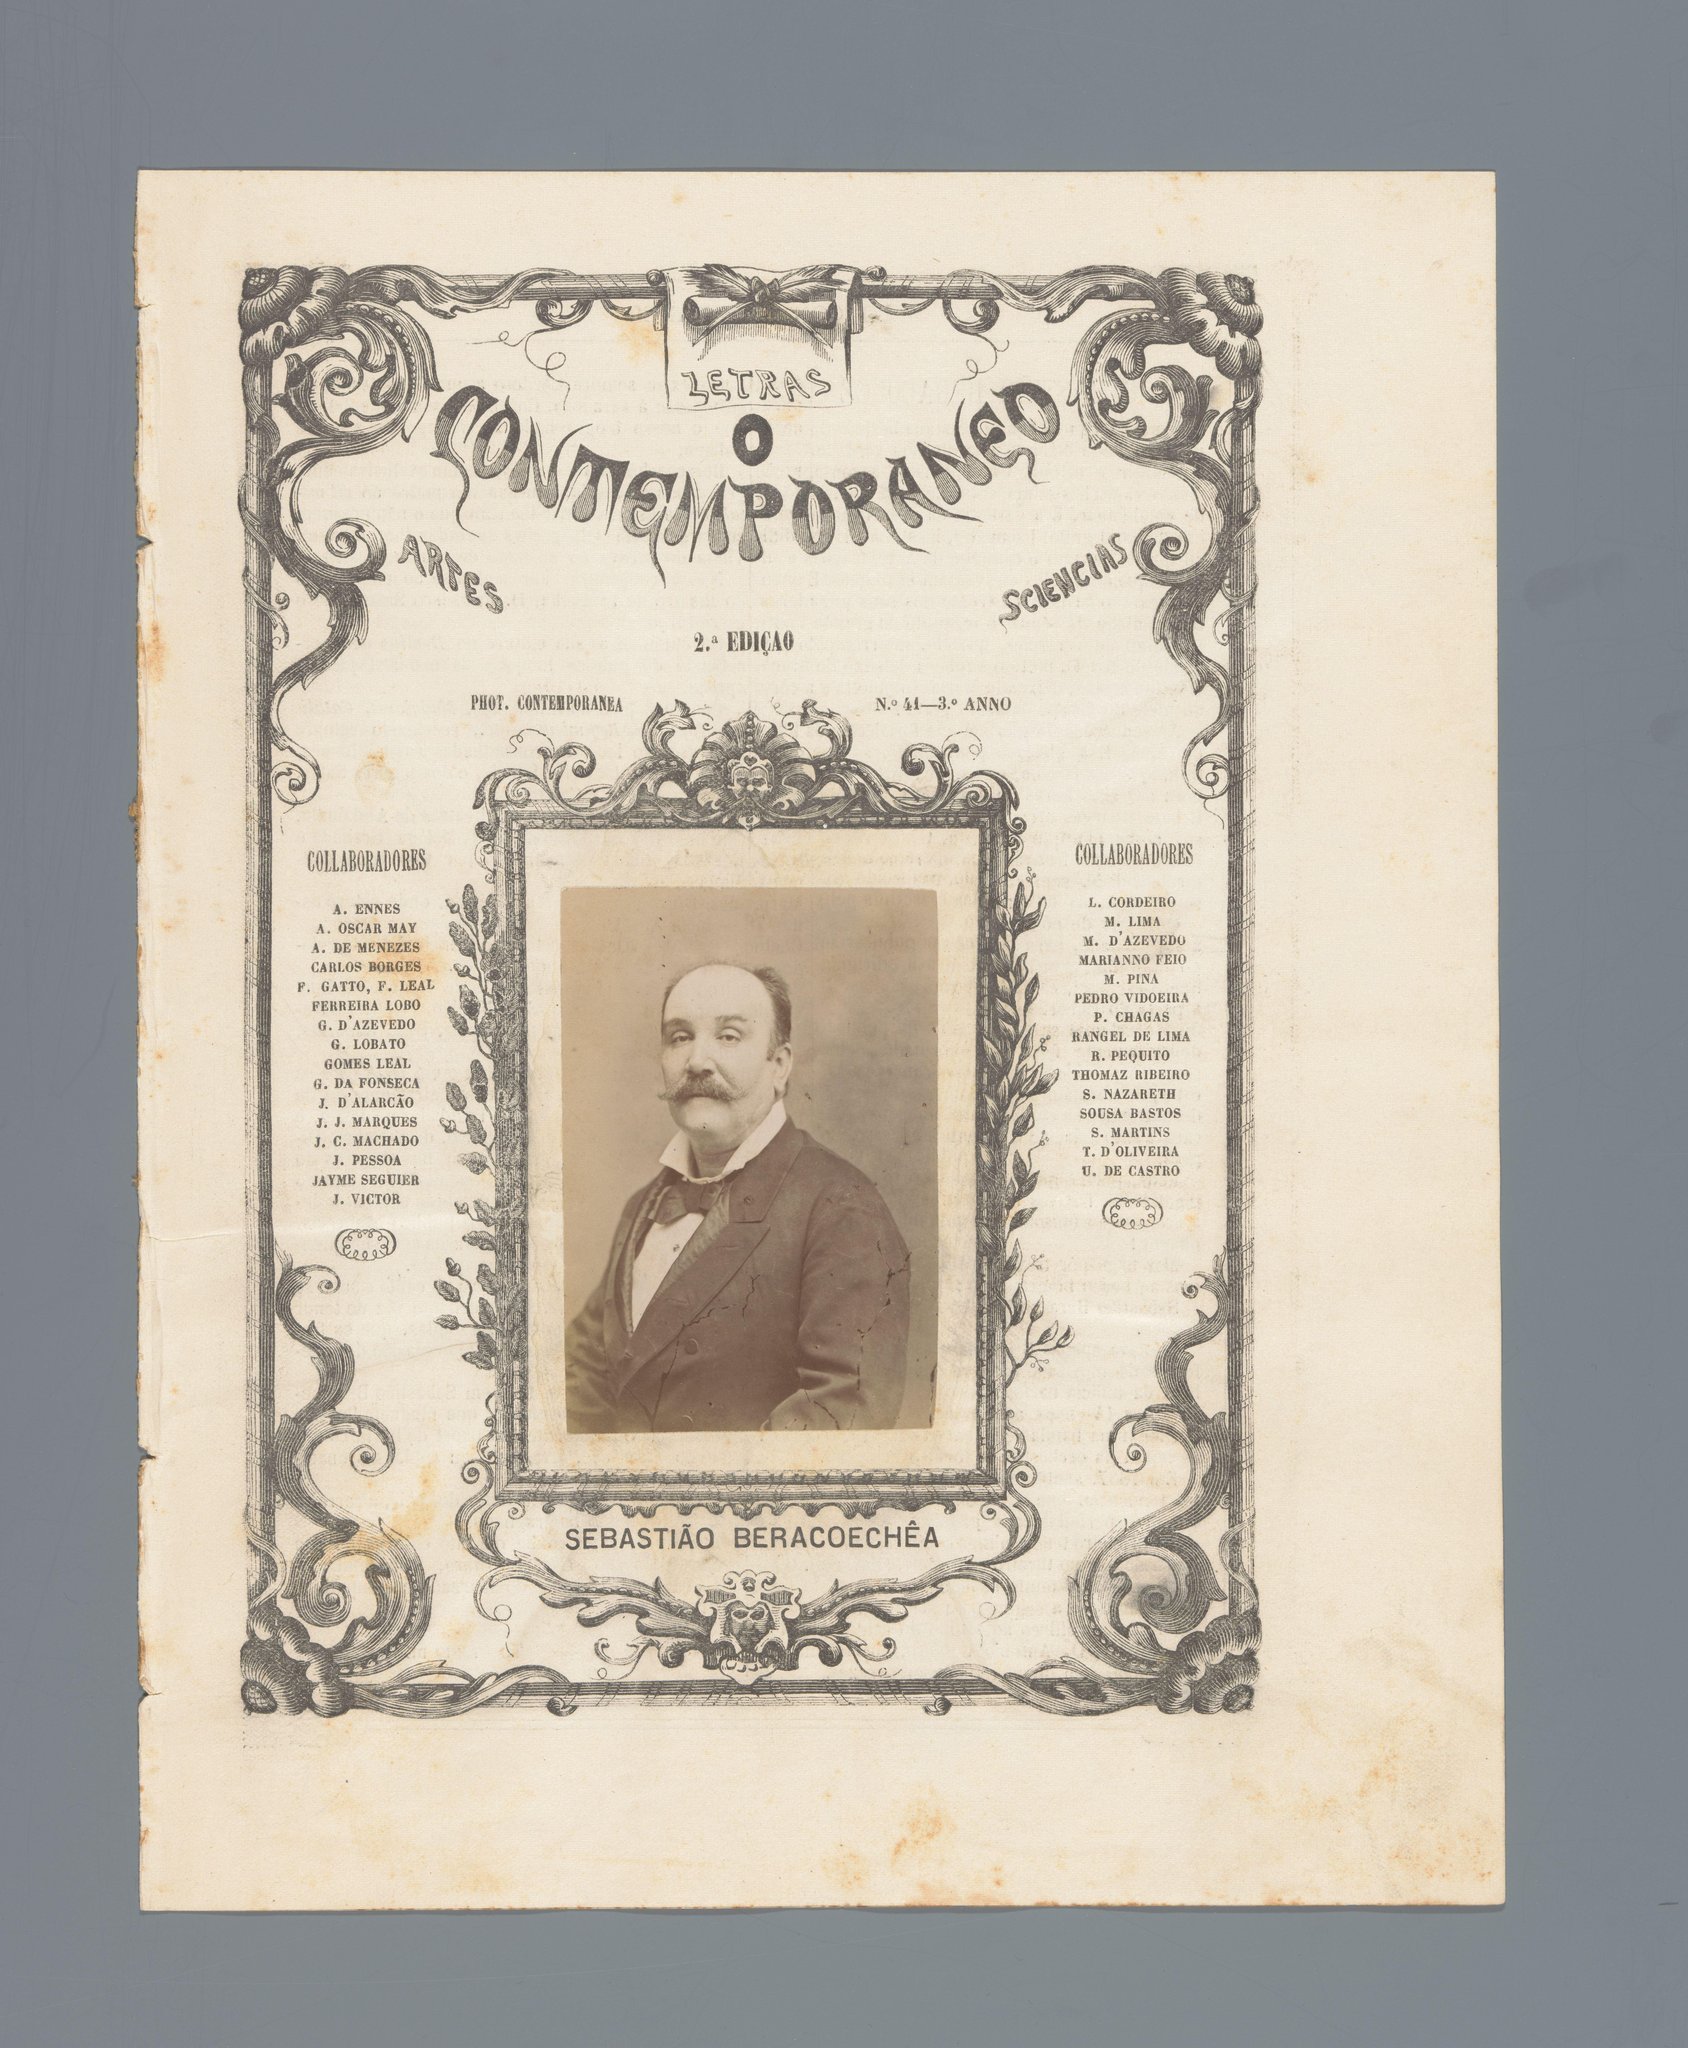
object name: photograph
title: O contemporaneo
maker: alfred fillon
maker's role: fotograaf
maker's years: 1825-1881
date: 1872-1877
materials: paper, photographic support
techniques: albumen print, printing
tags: historical persons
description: Op de voorpagina bevindt zich een portret van Sebastião Beracoechêa.